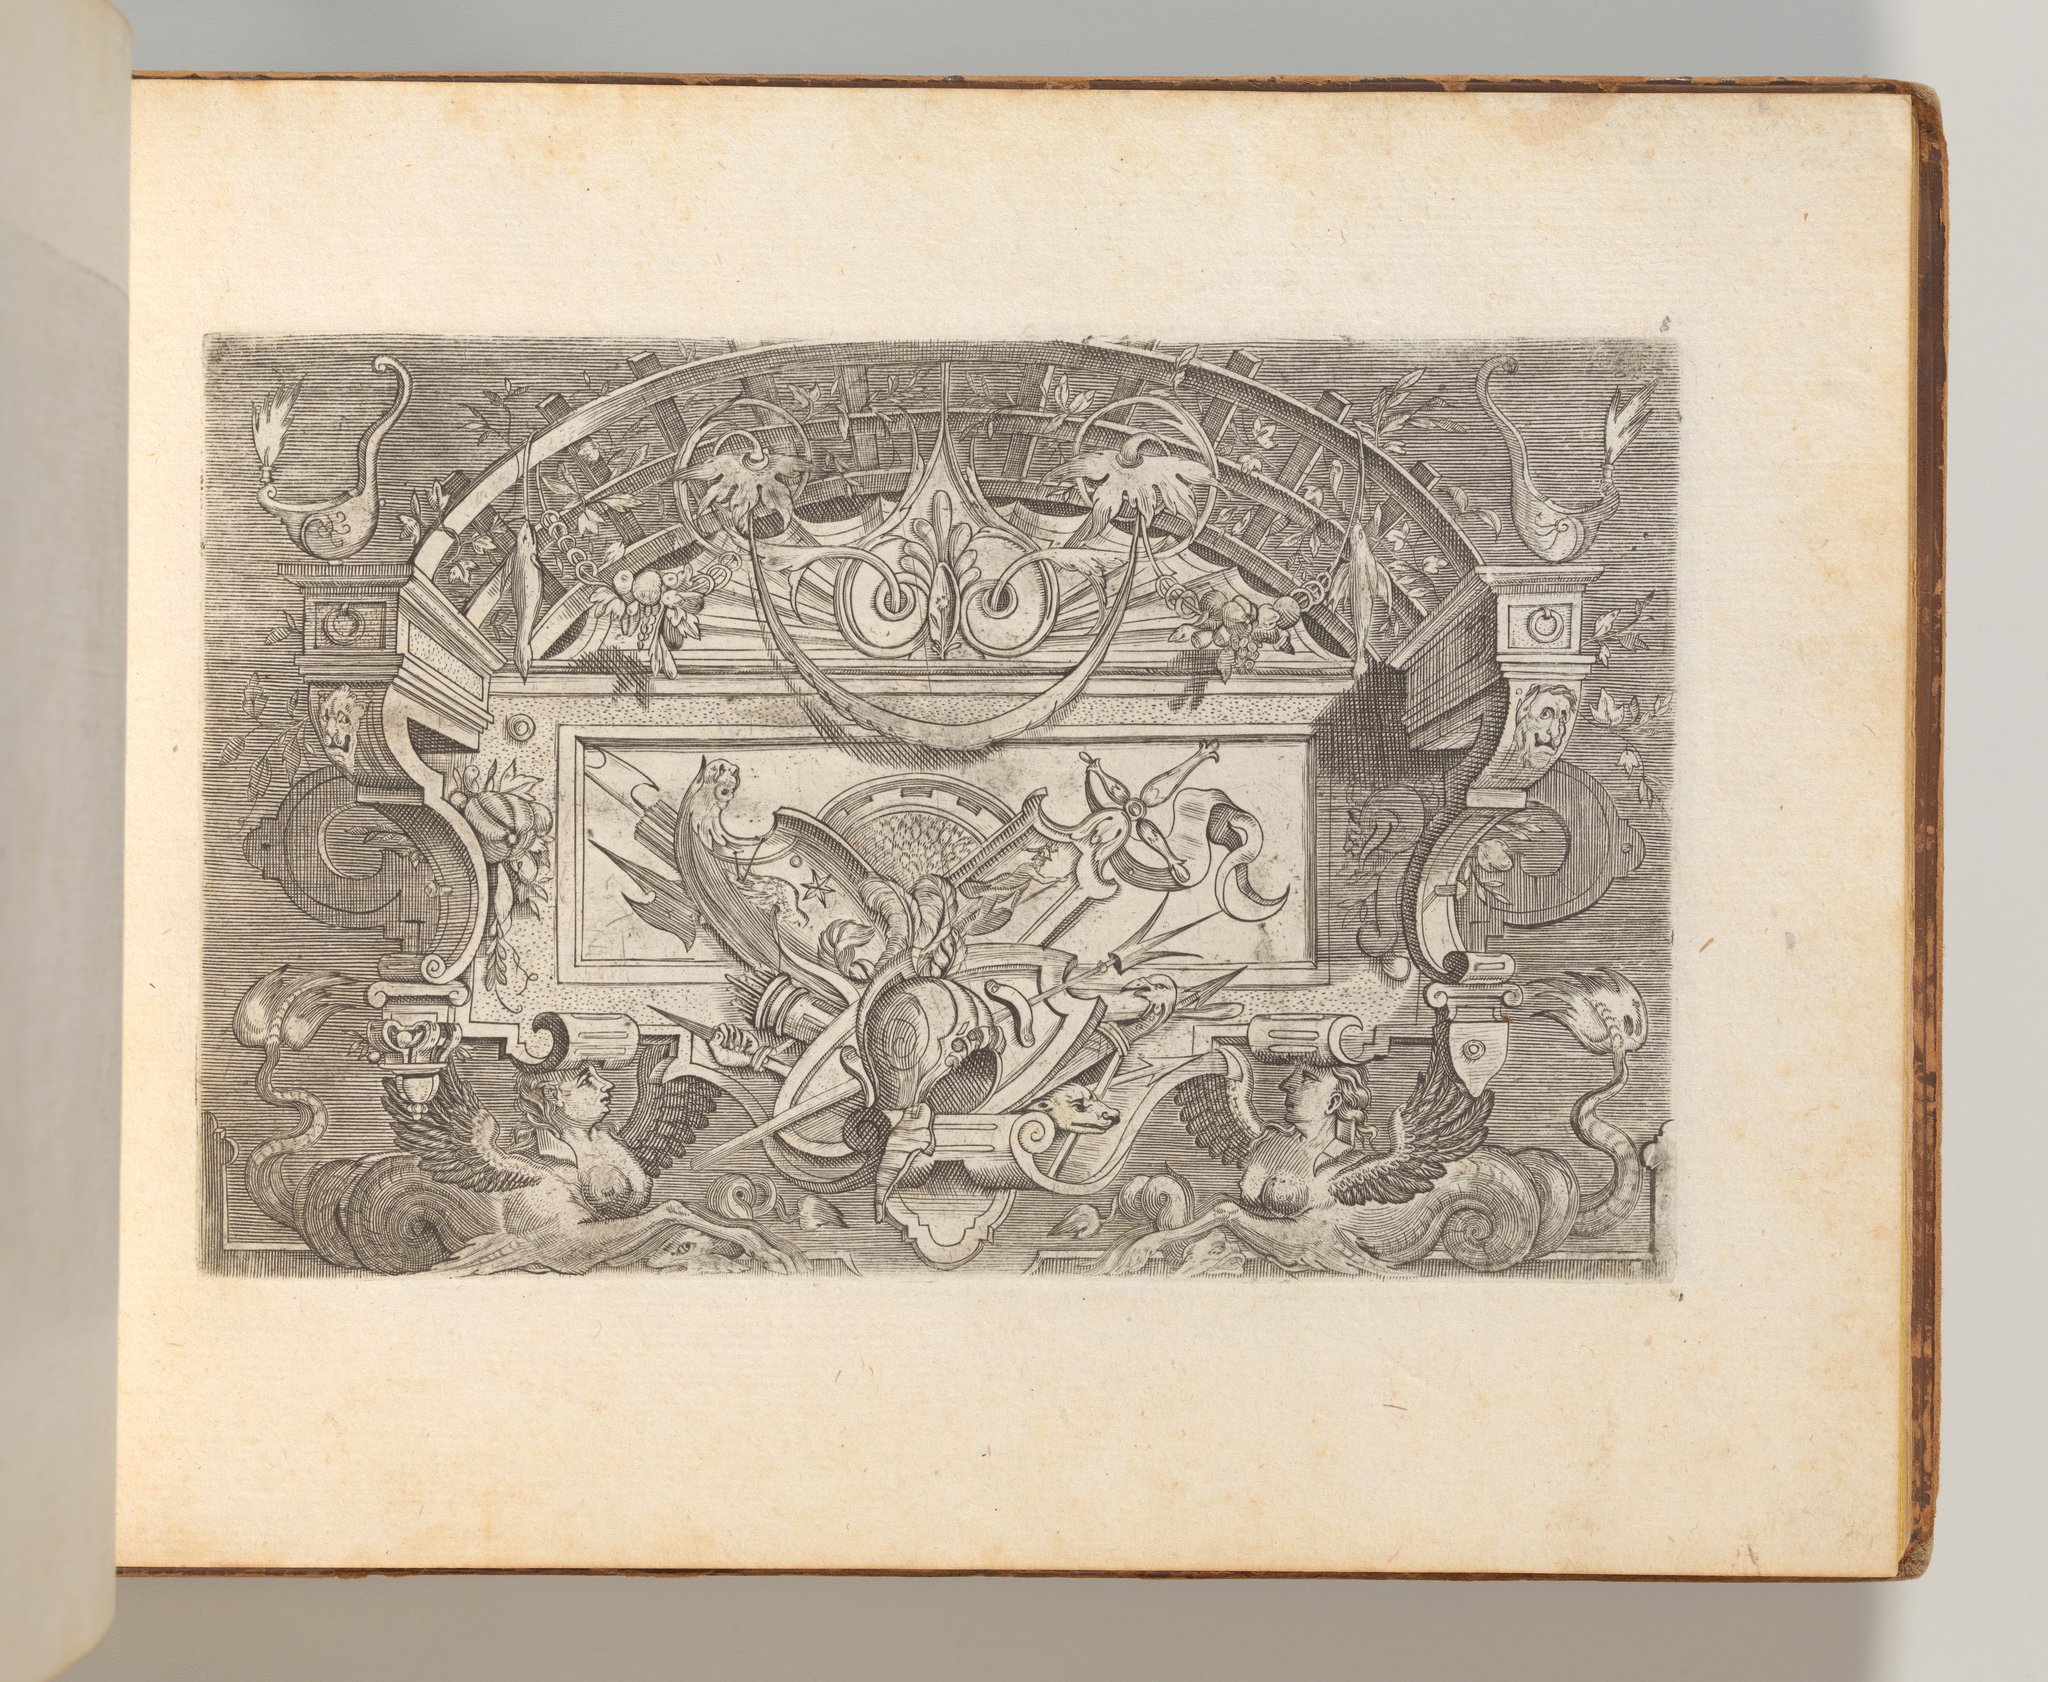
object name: album print ornament architecture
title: Targhe ed altri ornati di varie e capricciose invenzioni (Cartouches and other ornaments of various and capricious invention, page 8)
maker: jacob floris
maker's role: artist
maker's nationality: central european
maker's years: 1524-1581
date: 1773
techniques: engraving, etching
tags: cartouches